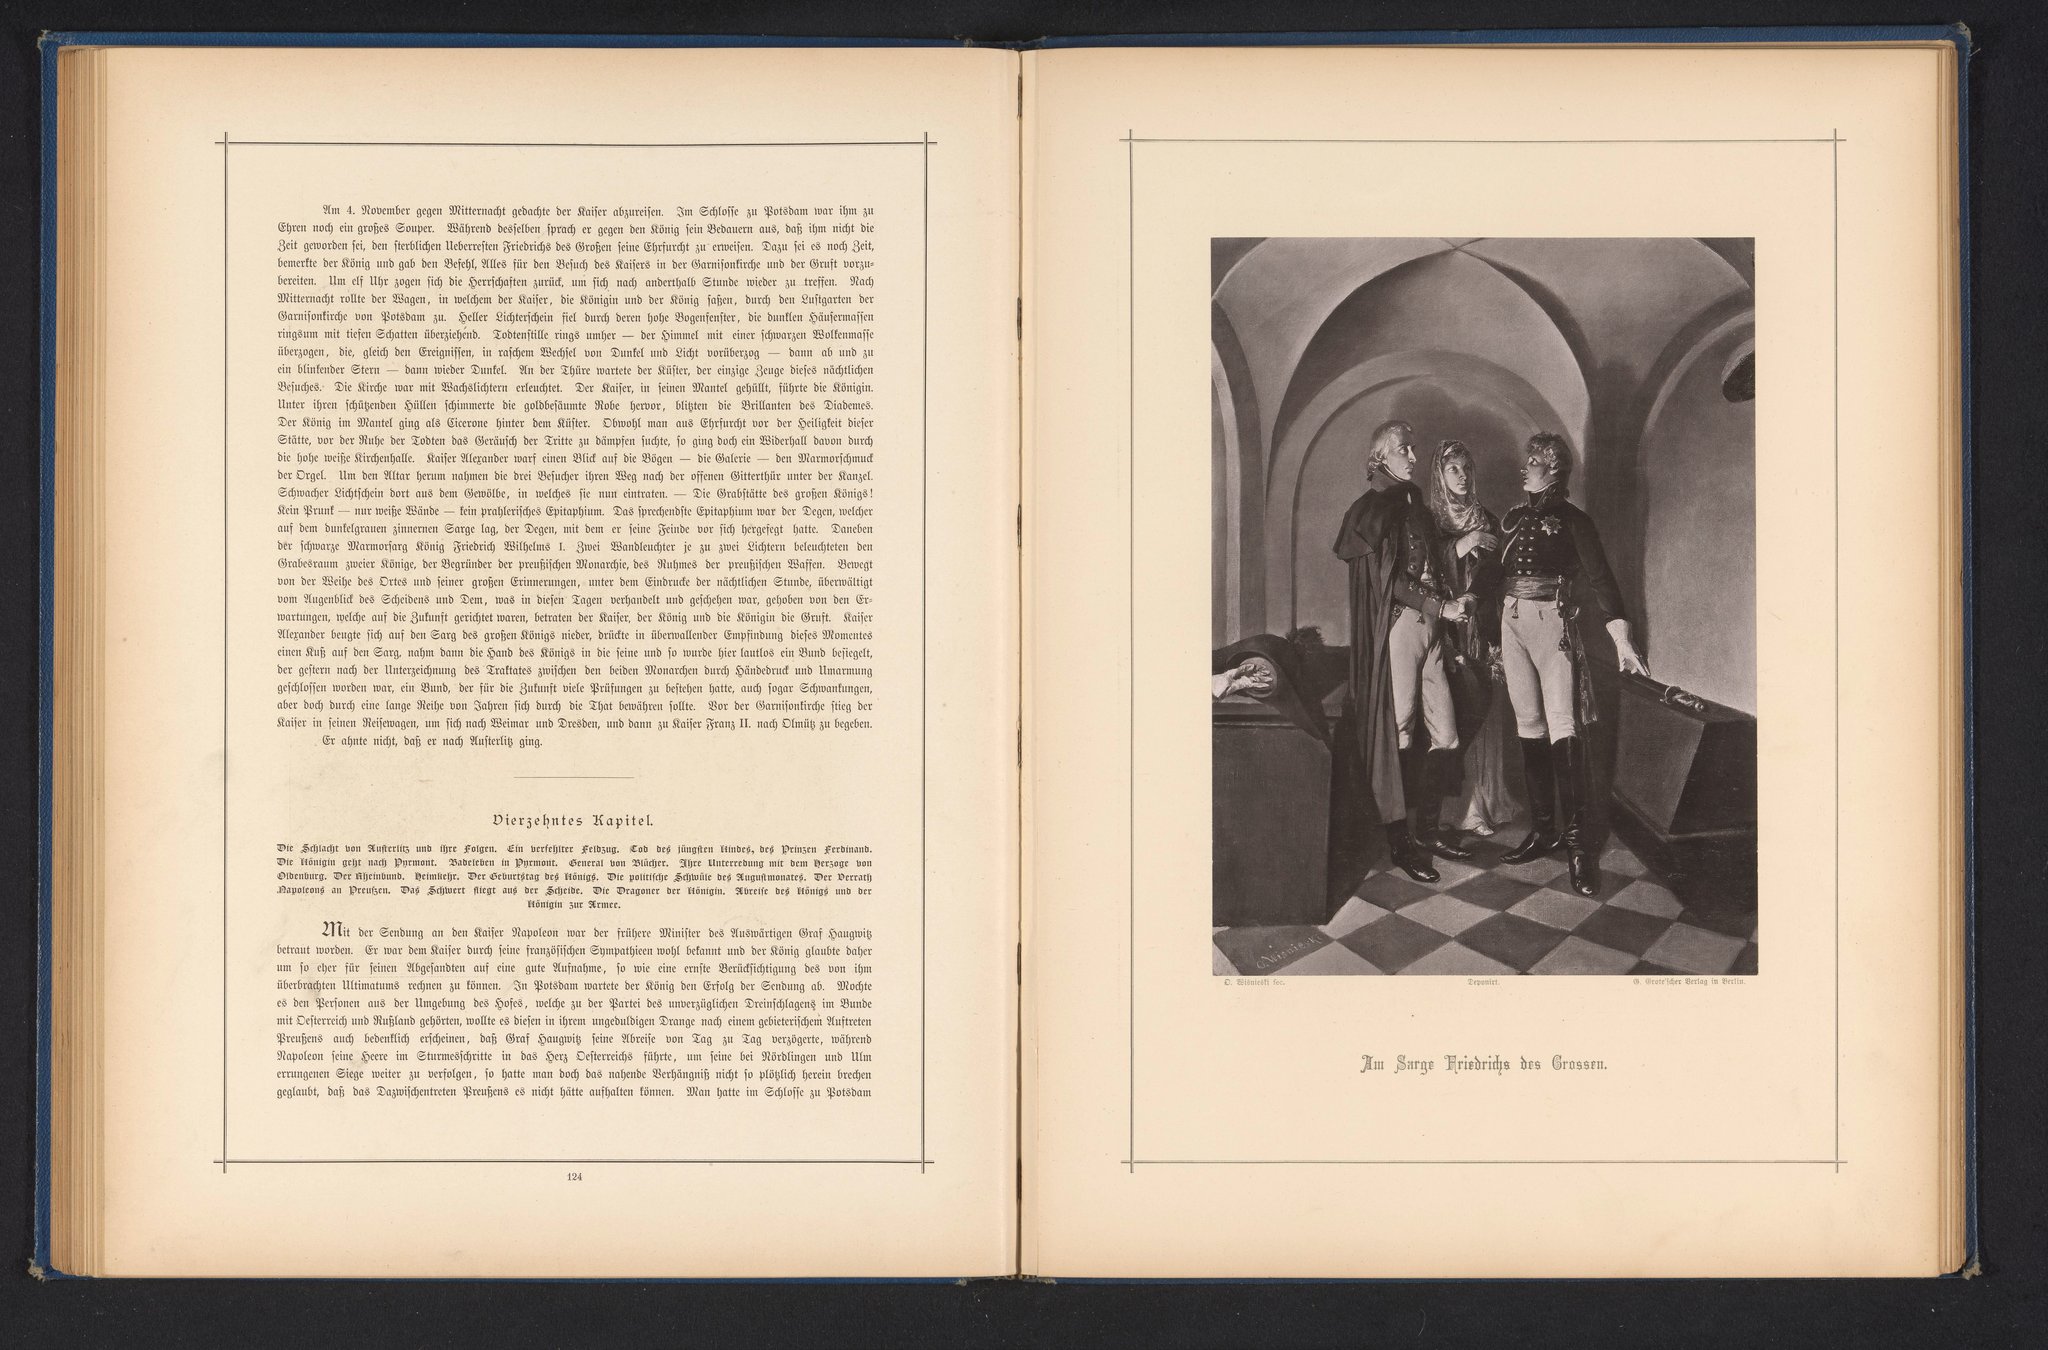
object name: photomechanical print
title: Fotoreproductie van een schilderij van Napoleon Bonaparte bij het graf van Frederik II van Pruisen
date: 1873-1883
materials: paper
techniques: photograph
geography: berlin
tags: frederick ii (king of prussia), napoleon i (emperor of the french), grave, tomb